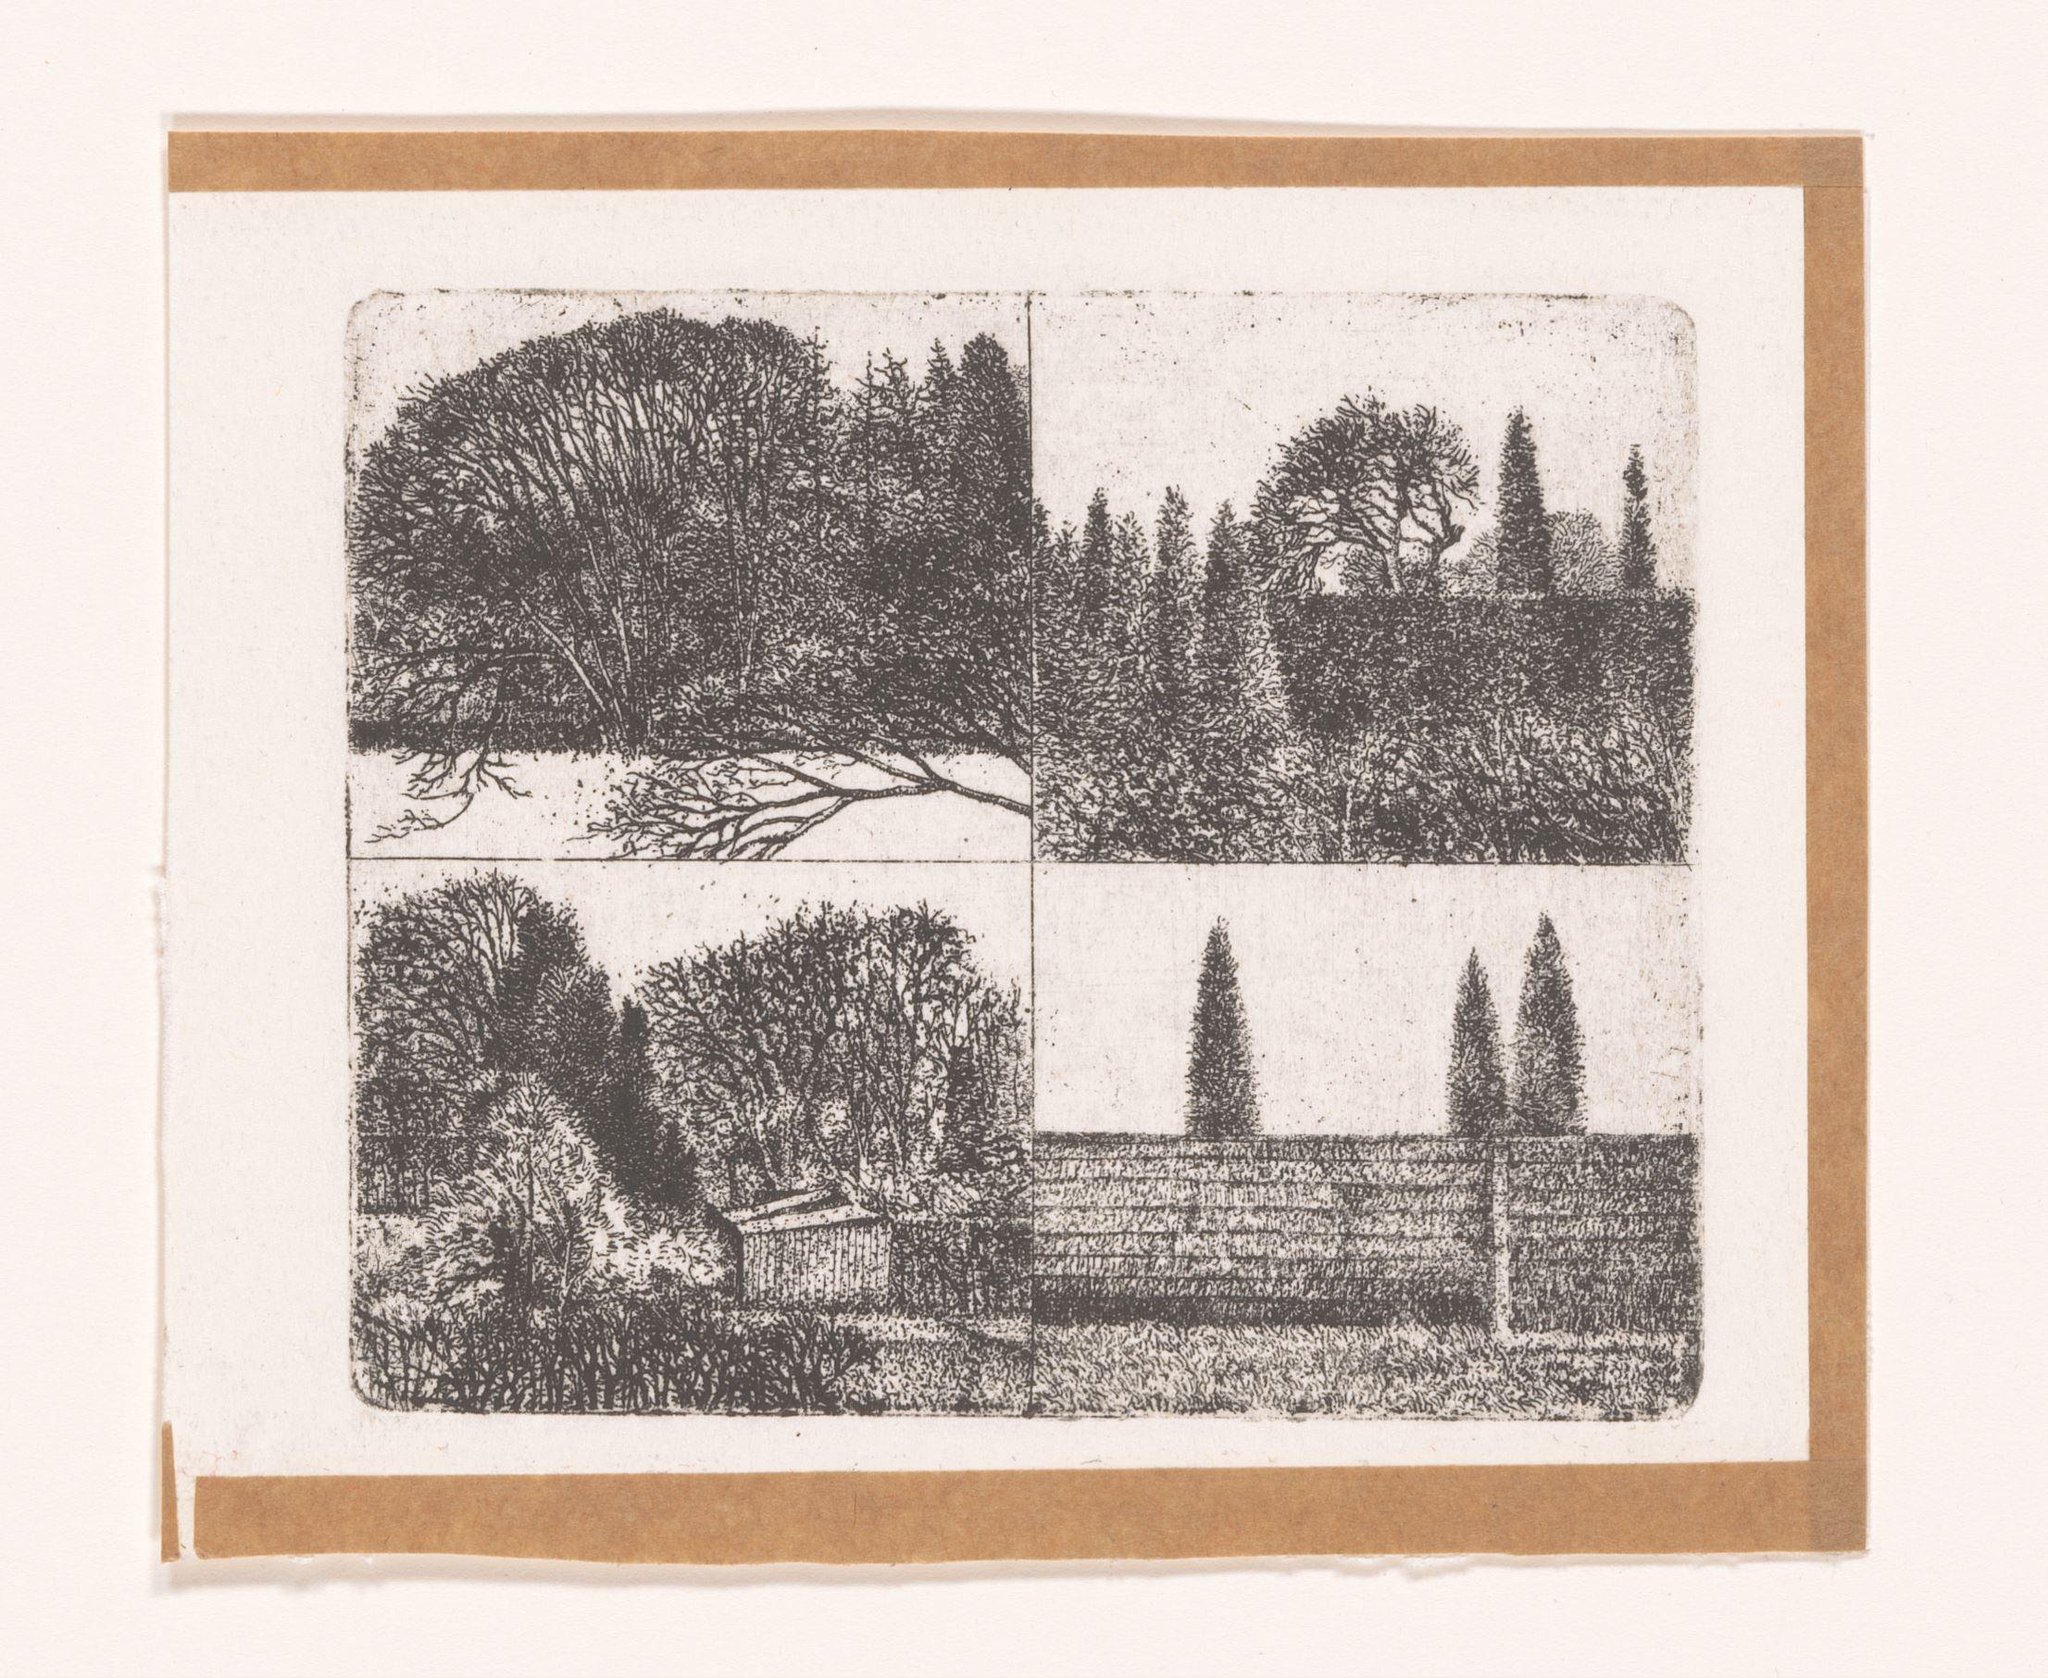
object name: print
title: Tuin (vier keer)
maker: kees stoop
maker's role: draughtsman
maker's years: 1929-2019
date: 1944-1990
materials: paper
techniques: etching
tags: garden, backyard